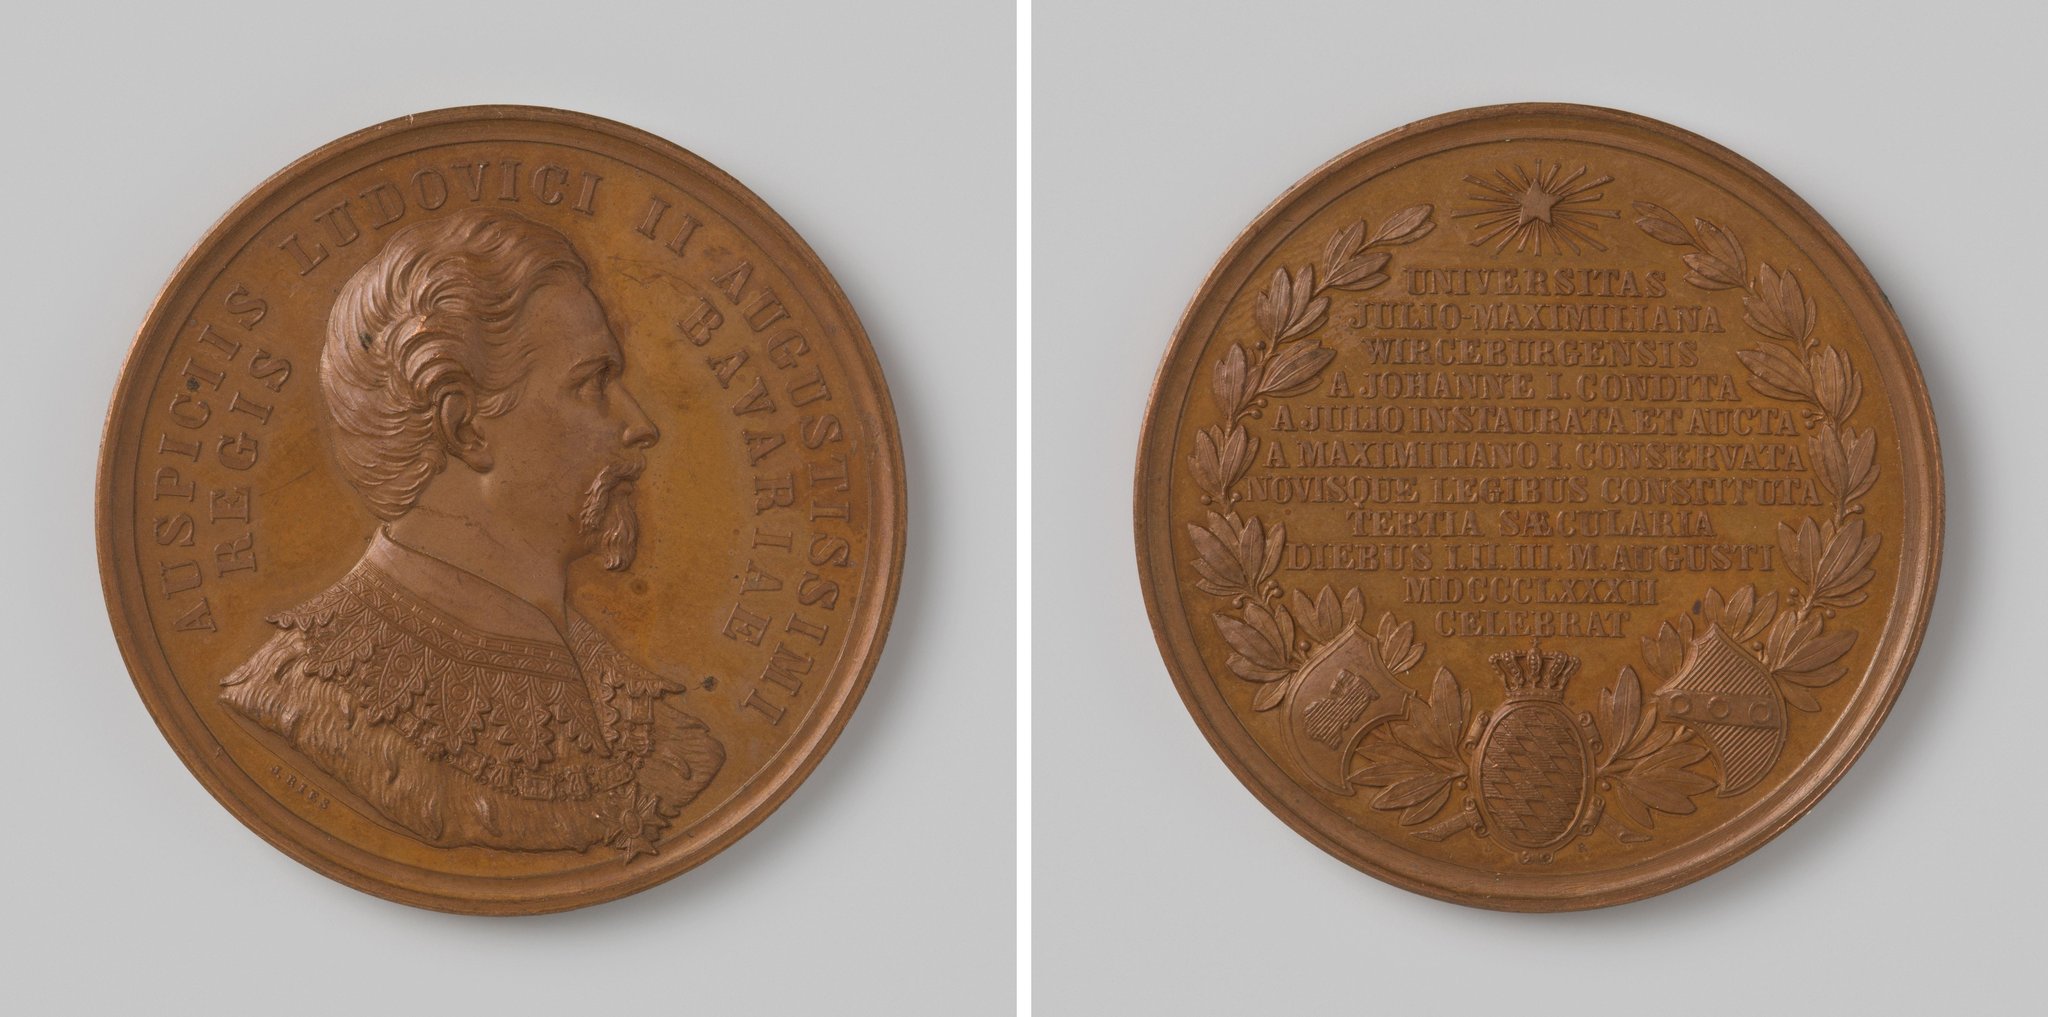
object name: history medal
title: Driehonderdjarig bestaan van de Universiteit van Würzburg 1882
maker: j. ries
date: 1882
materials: bronze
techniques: striking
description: Bronzen penning, op de voorzijde het borstbeeld van Koning Lodewijk van Beieren naar recht met dubbel omschrift, op de keerzijde elf regels tekst onder een ster, tussen twee lauwertakken waarop drie wapenschilden.